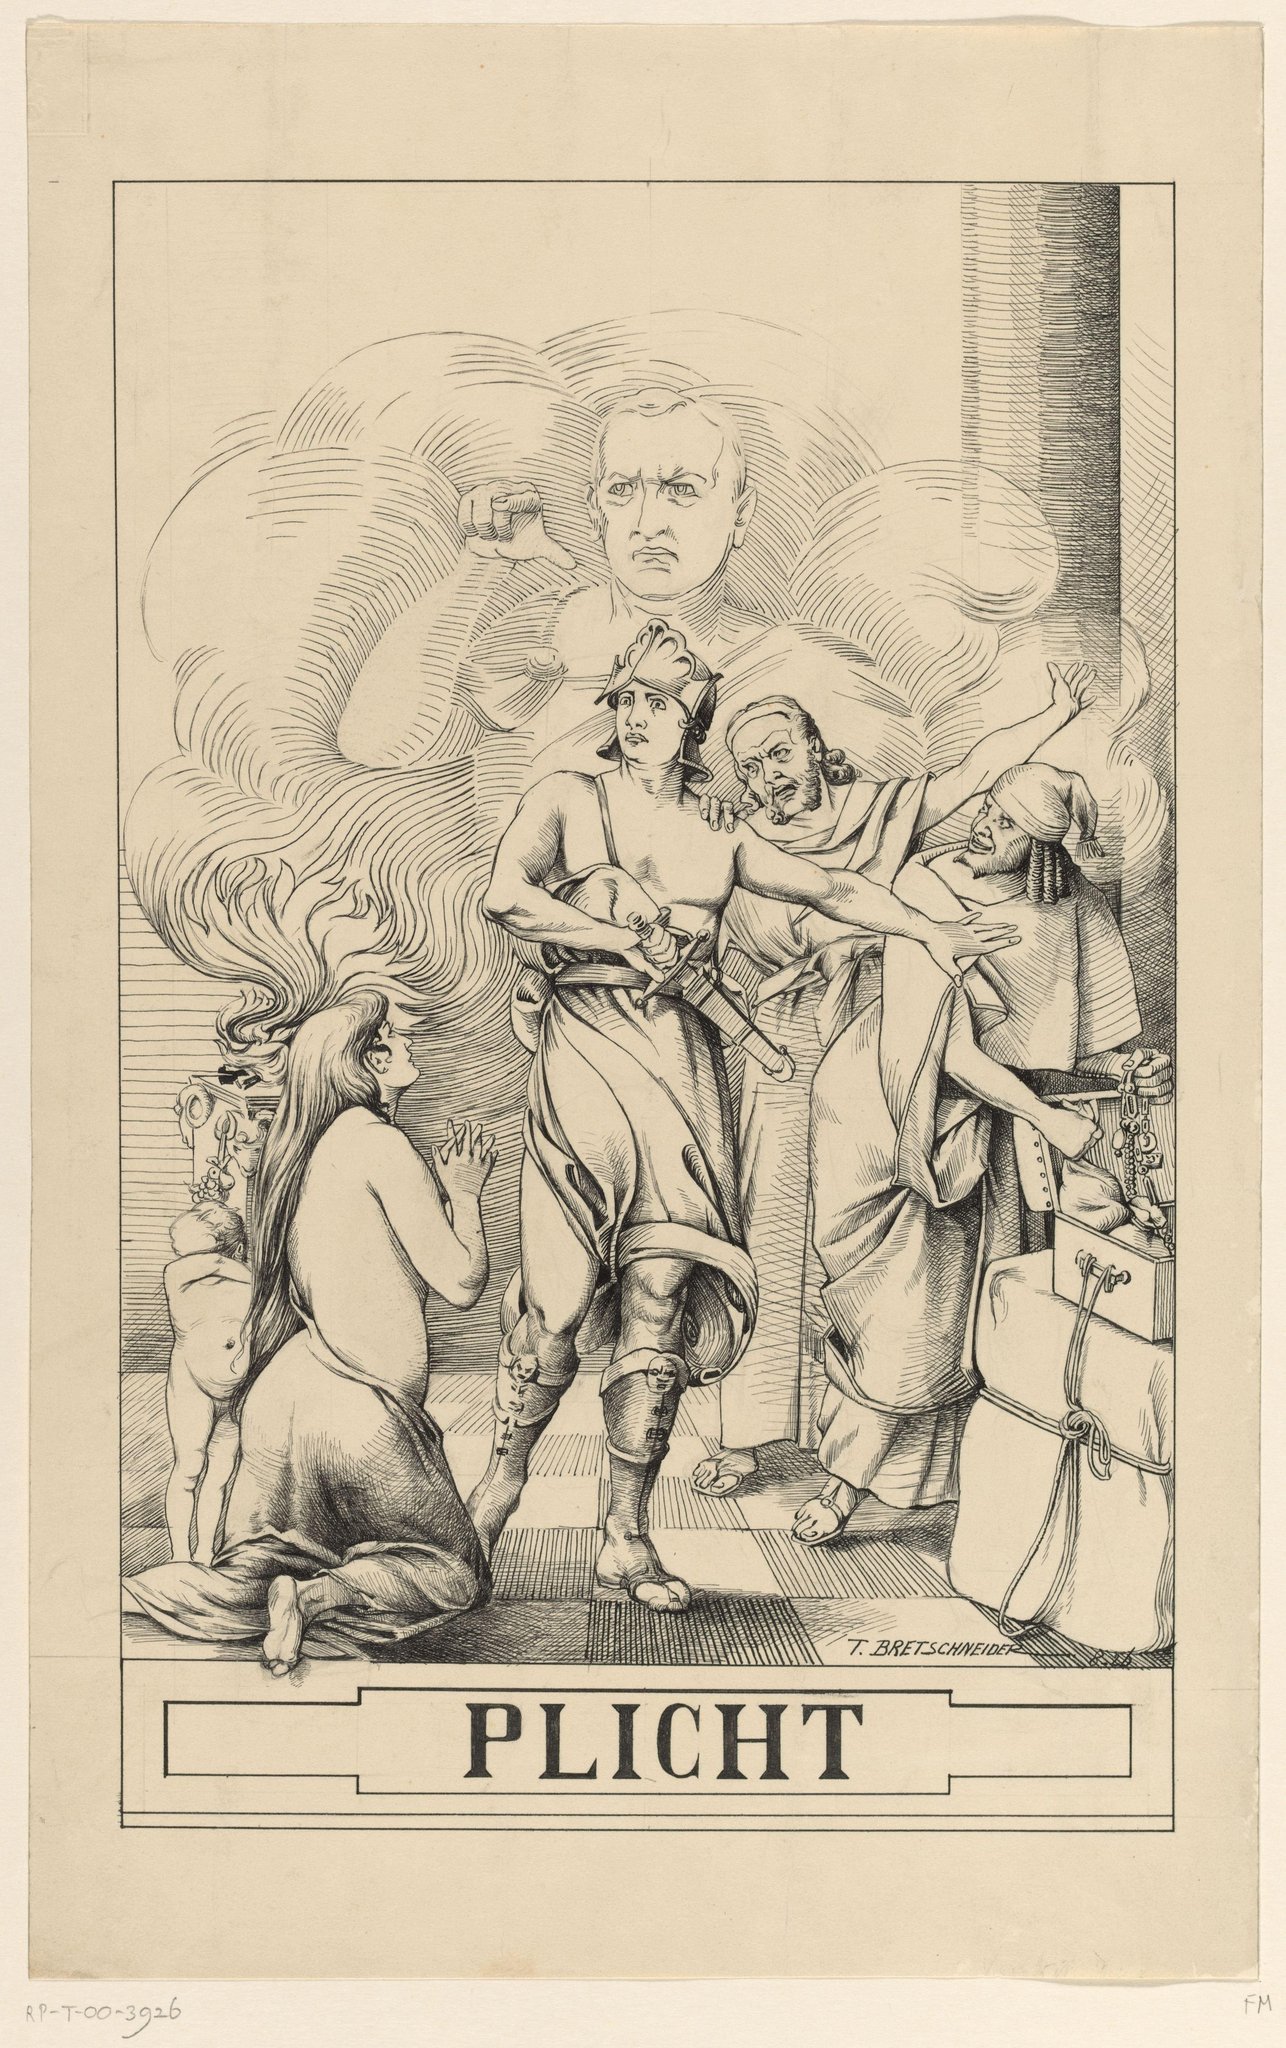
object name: drawing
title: Plicht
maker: j. bretschneider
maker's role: draughtsman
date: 1908-1926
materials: paper, pencil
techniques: pen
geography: netherlands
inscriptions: collector's mark: Lugt 2228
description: Ontwerptekening voor een allegorische spotprent, augustus 1926. Een man in antieke kleding staat op het punt om zijn zwaard te trekken om te verhinderen dat een (mogelijk Joodse) man sieraden uit een doosje steelt. Links knielt een halfnaakte vrouw die de soldaat smeekt om in te grijpen. Achter de figuren in het rook van een altaar de gestalte van een wijzende man.